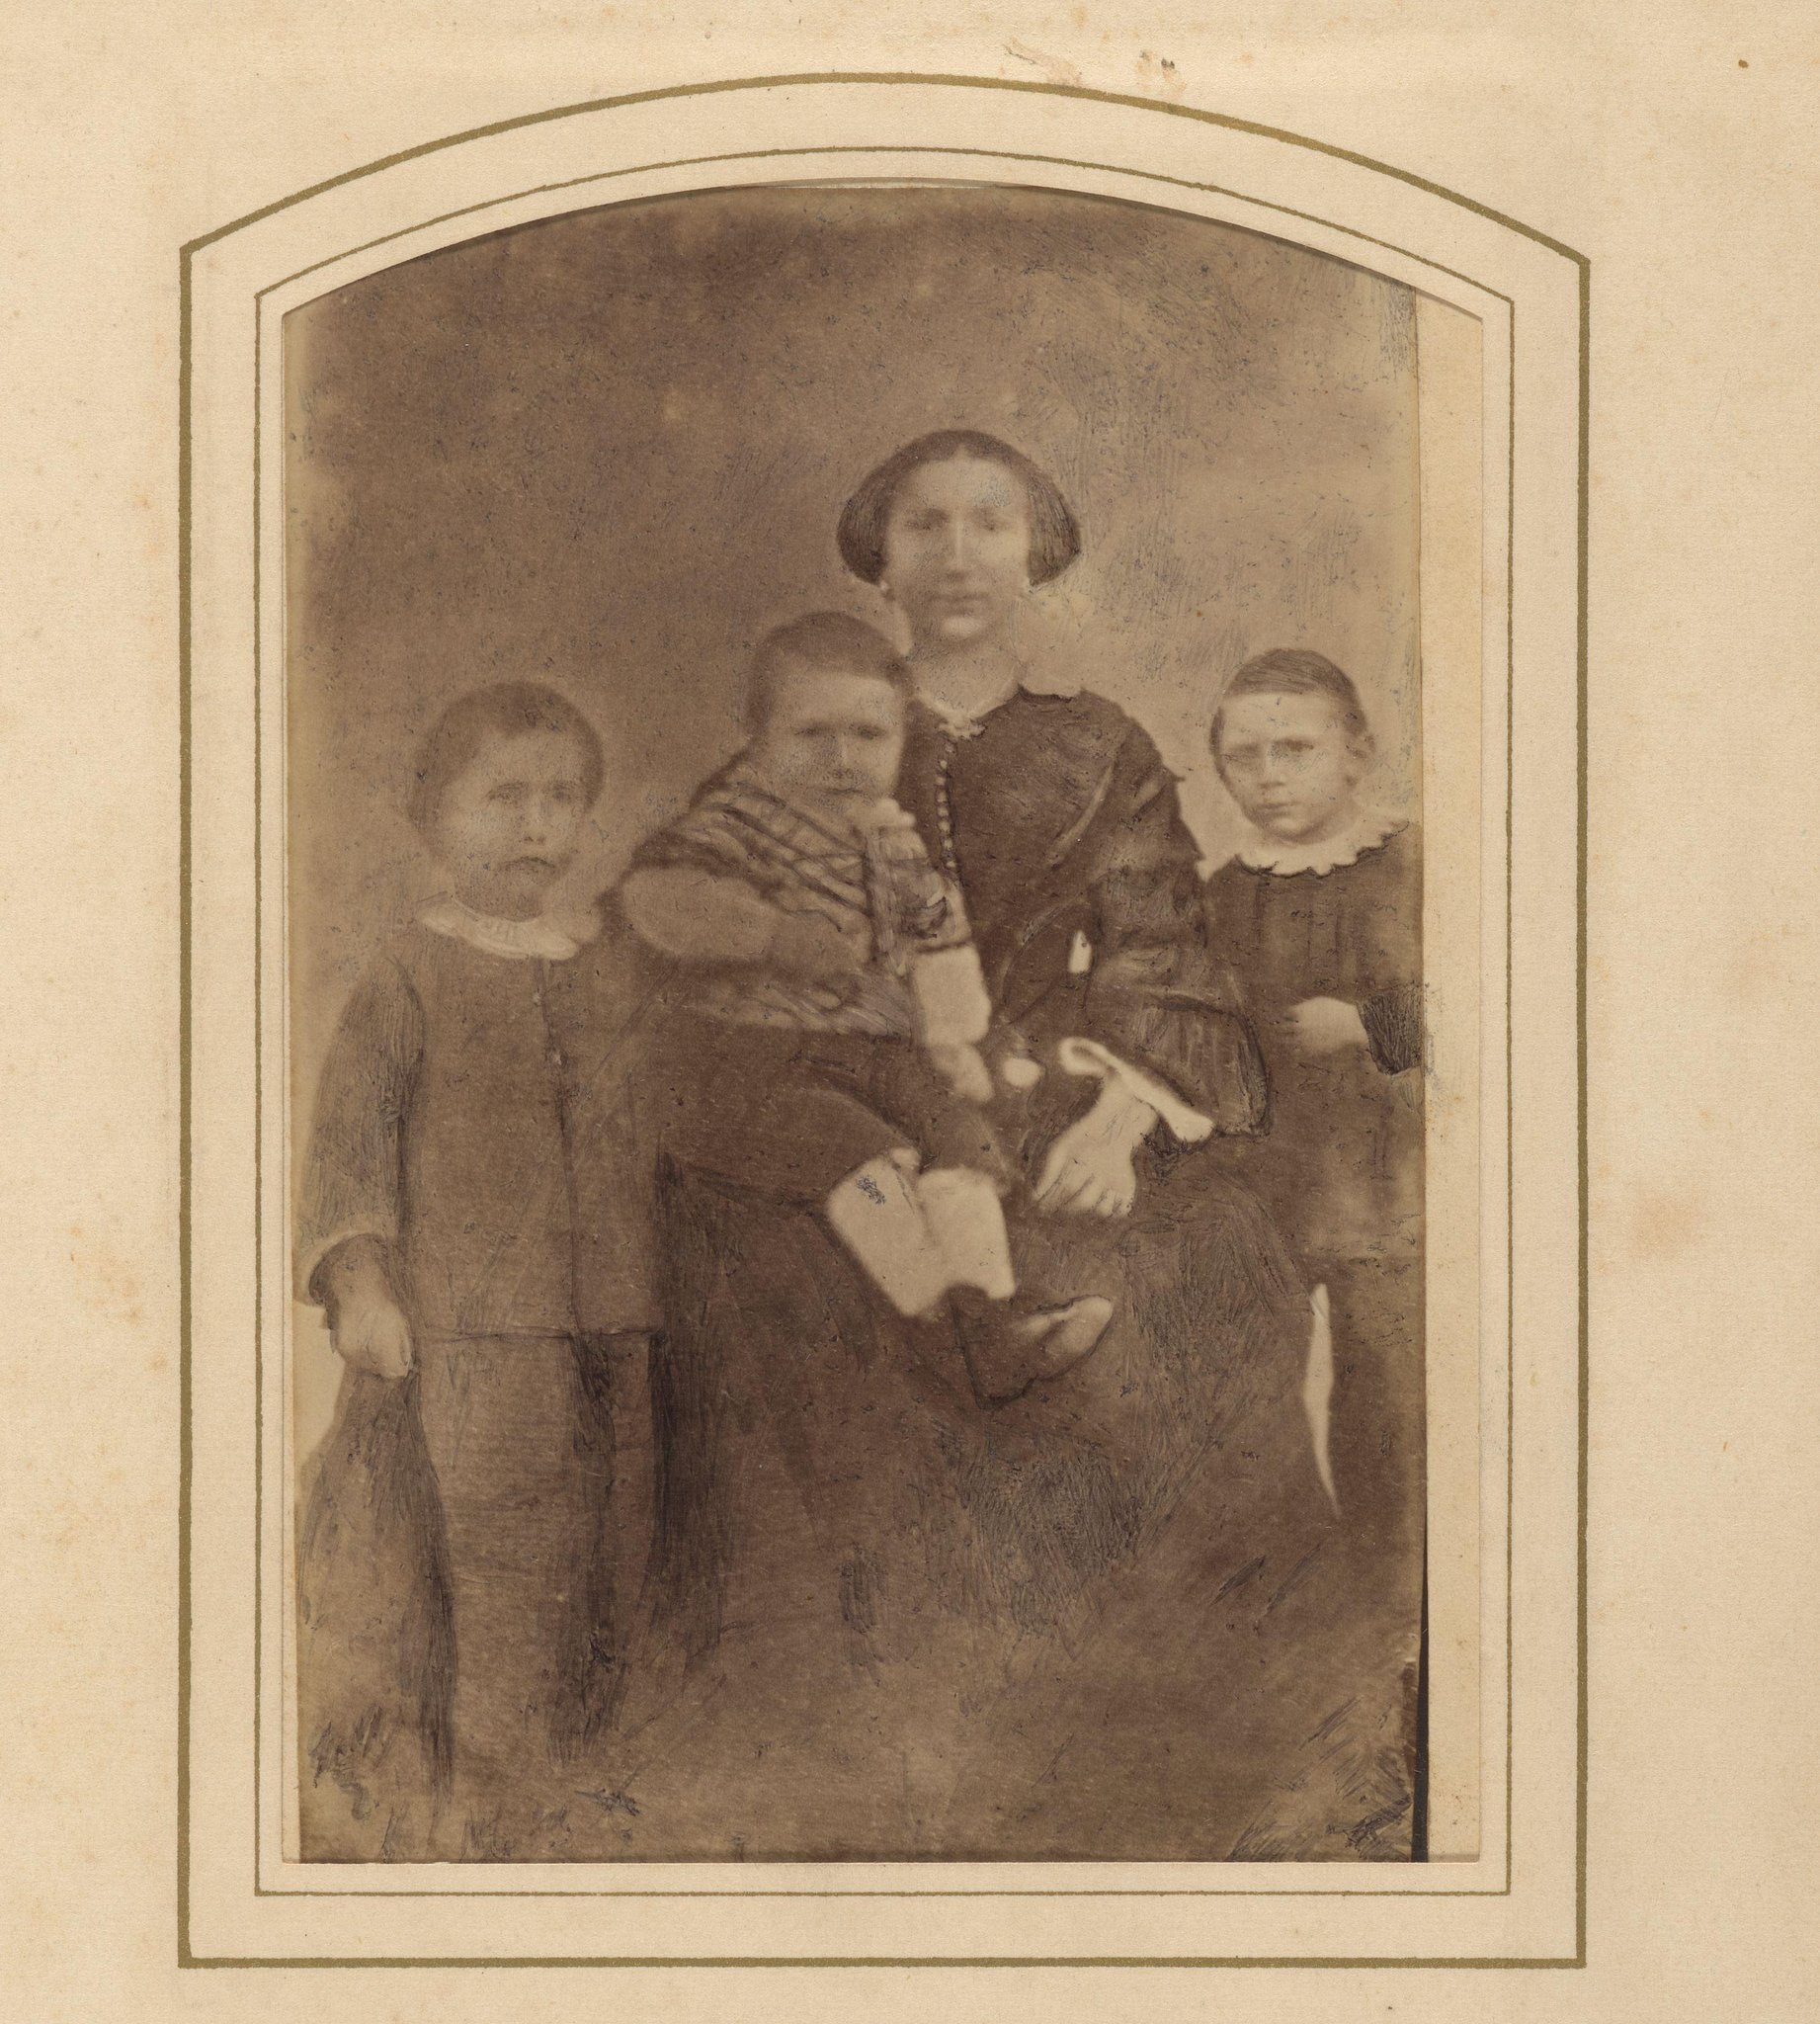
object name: cabinet photograph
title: Portret van een vrouw en drie kinderen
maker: Anonymous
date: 1850-1900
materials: cardboard, photographic support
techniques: albumen print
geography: netherlands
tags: adult woman, child (+ three persons), anonymous historical persons portrayed in a group, in a group-portrait